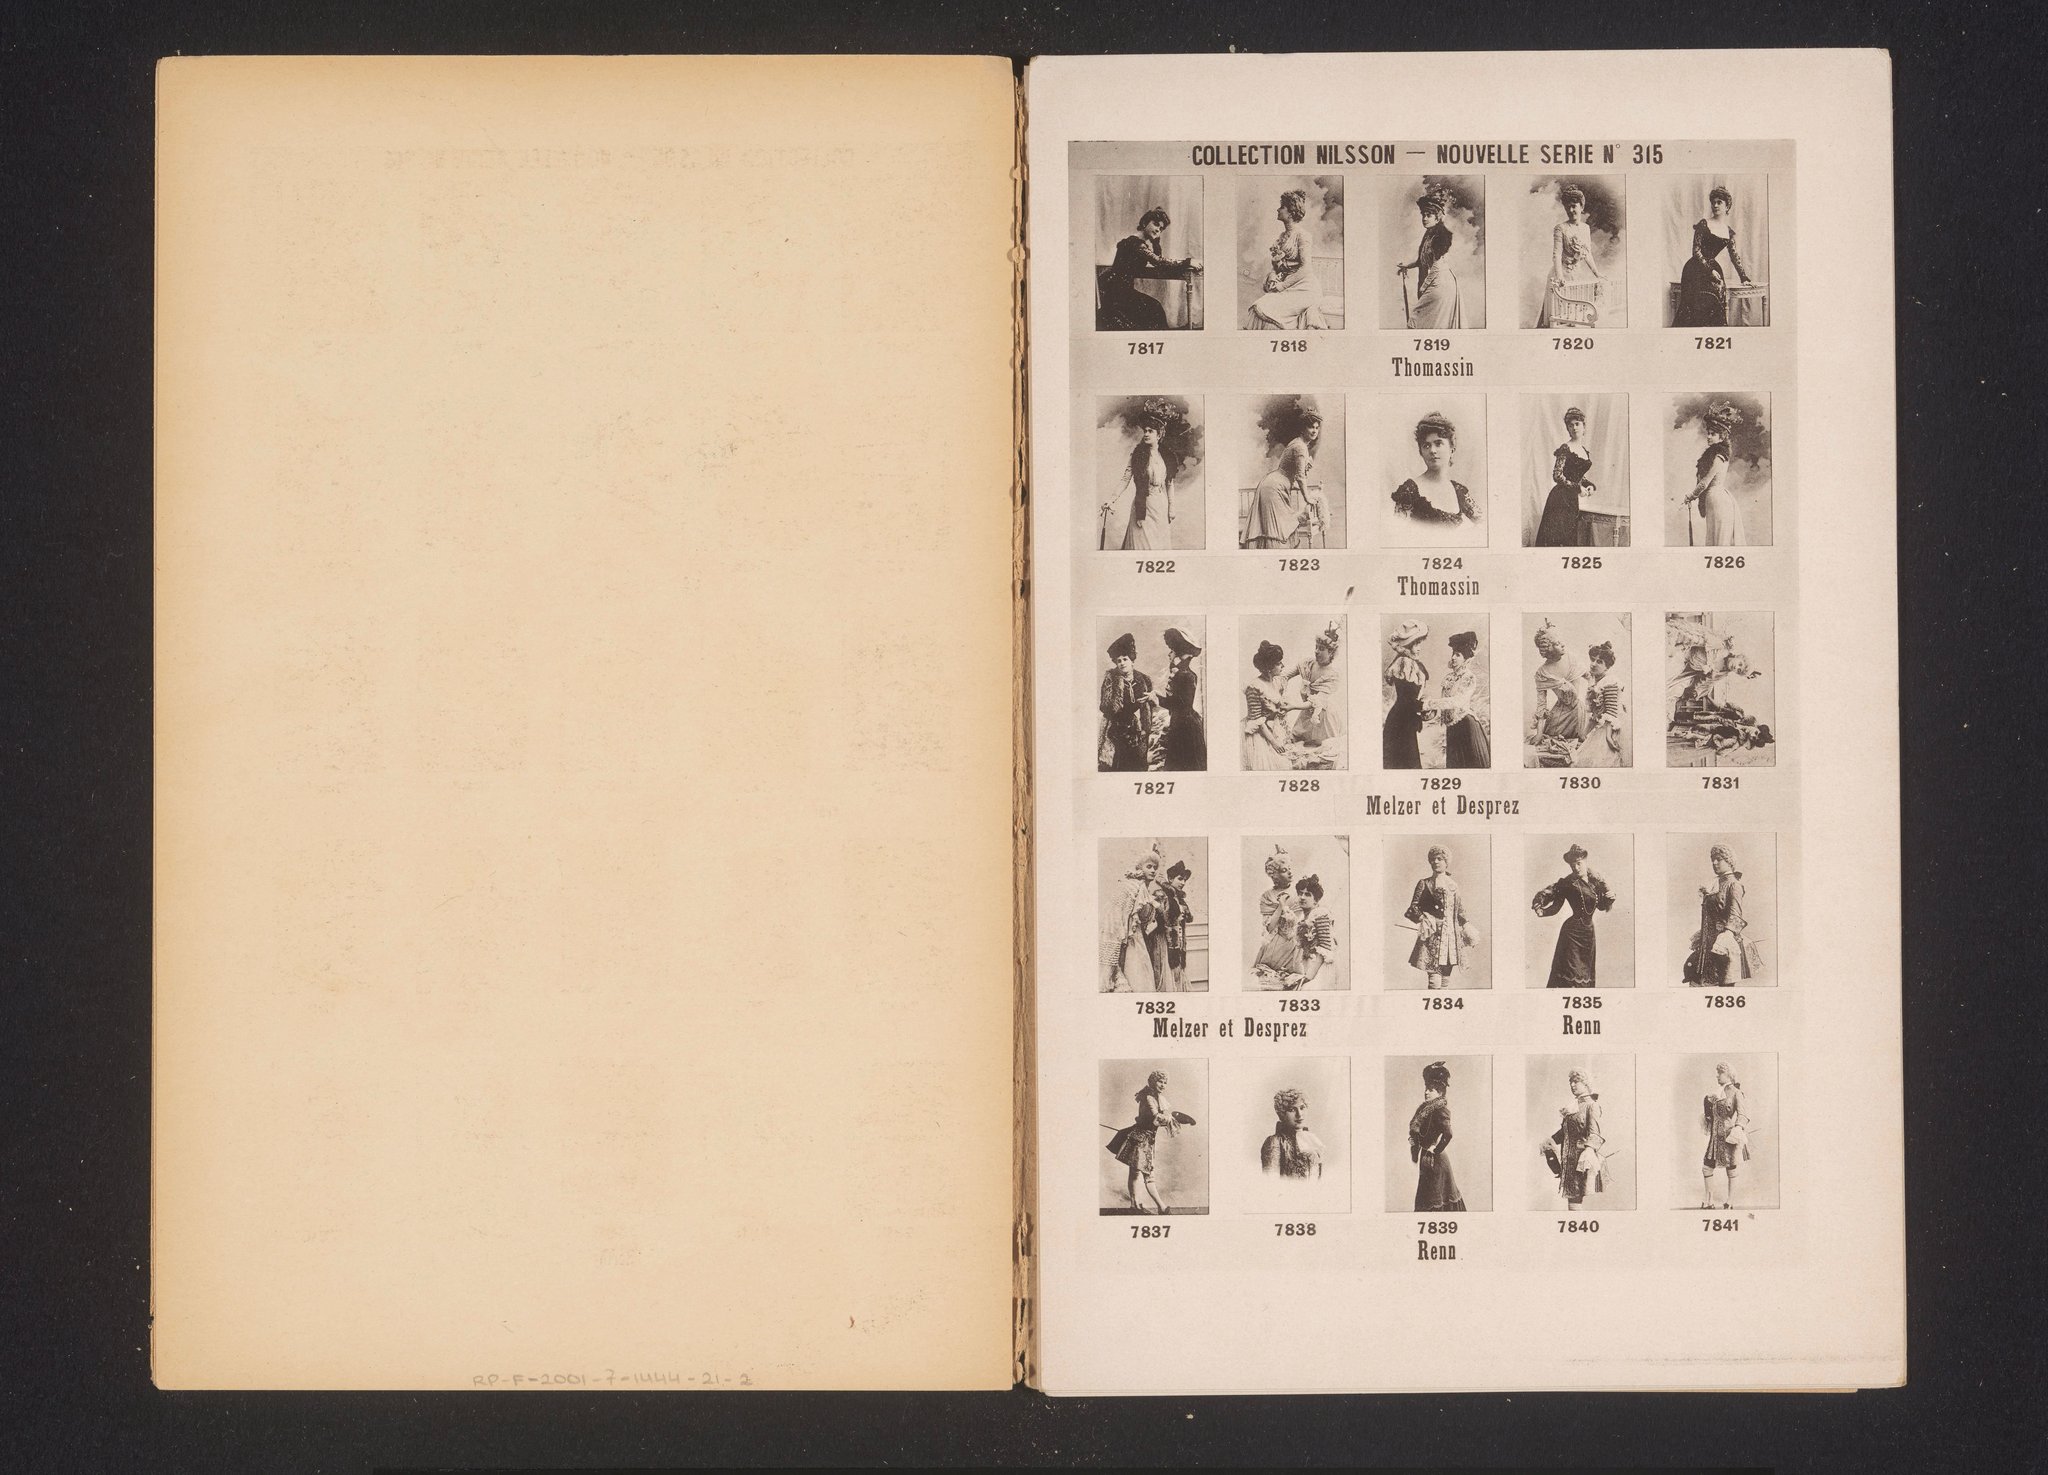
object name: photomechanical print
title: Collection Nilsson - Nouvelle Série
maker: Anonymous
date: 1895-1900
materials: paper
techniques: photograph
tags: historical persons - bb - woman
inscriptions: number: ‘No 315’